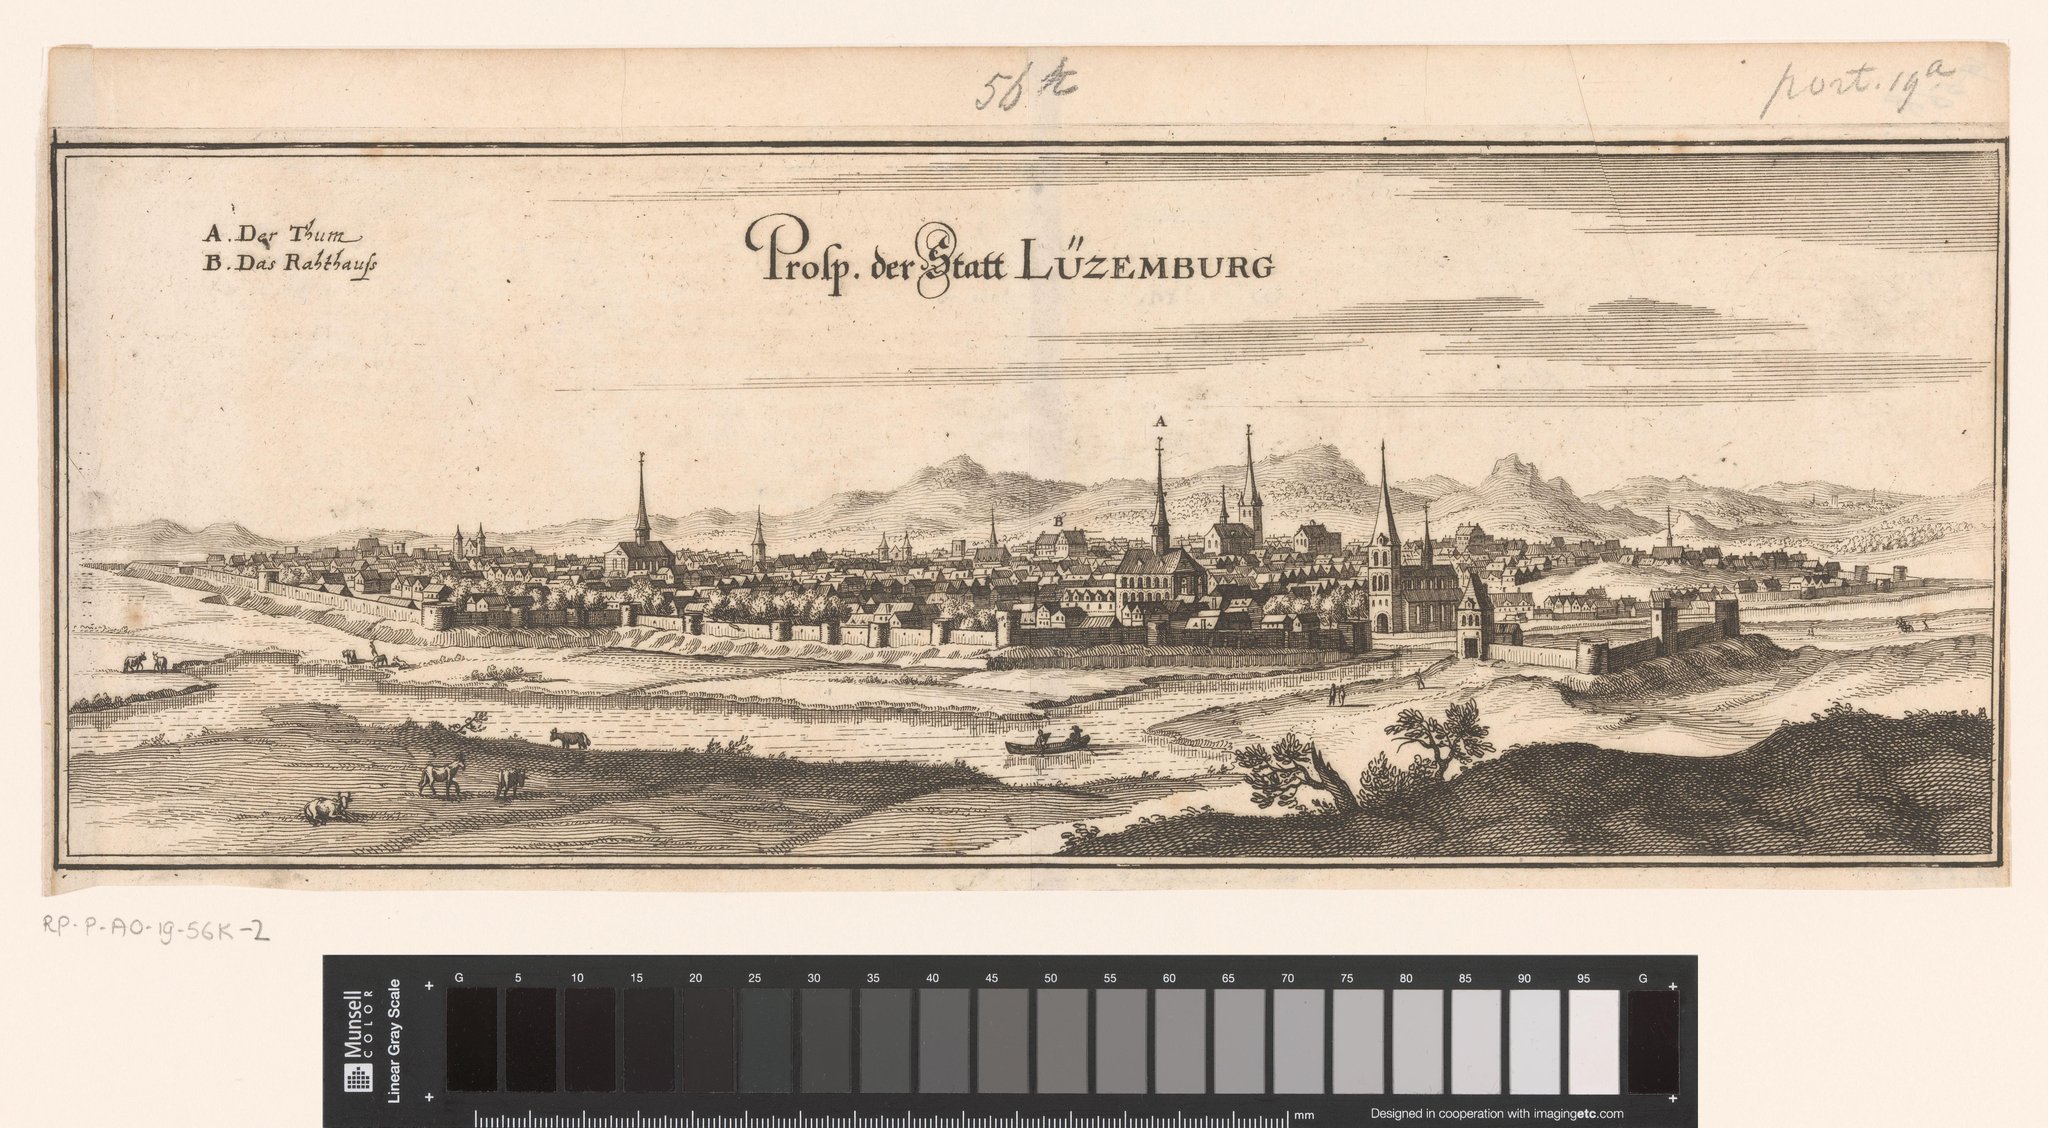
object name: print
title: Prosp. der statt Lüzemburg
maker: caspar merian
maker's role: print maker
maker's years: 1627-1689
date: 1654-1700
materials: paper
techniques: engraving, etching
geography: frankfurt am main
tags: church (exterior), prospect of city, town panorama, silhouette of city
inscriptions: collector's mark: Lugt 2228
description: Prent gebruikt in: Zeiller, Martin. M.Z. Topographia Circuli Burgundici Oder Beschreibung une Eigentliche Abbildung der Vornehmsten Örter in dem Hochlöblichen Burgund- un Niderlandischen Crayse. Frankfurt am Main: Caspar Merian, 1654. Of in: Zeiller, Martin. M. Z. Topographia Germaniae-Inferioris vel Circuli-Burgundici, das ist Beschreibung (…). Frankfurt am Main: Caspar Merian, 1659. Of in een van de twee latere uitgaven van deze publicatie die, hoewel het jaar 1659 erin staat vermeld als jaar van uitgave, zijn uitgegeven in respectievelijk ca. 1670 en ca. 1700.